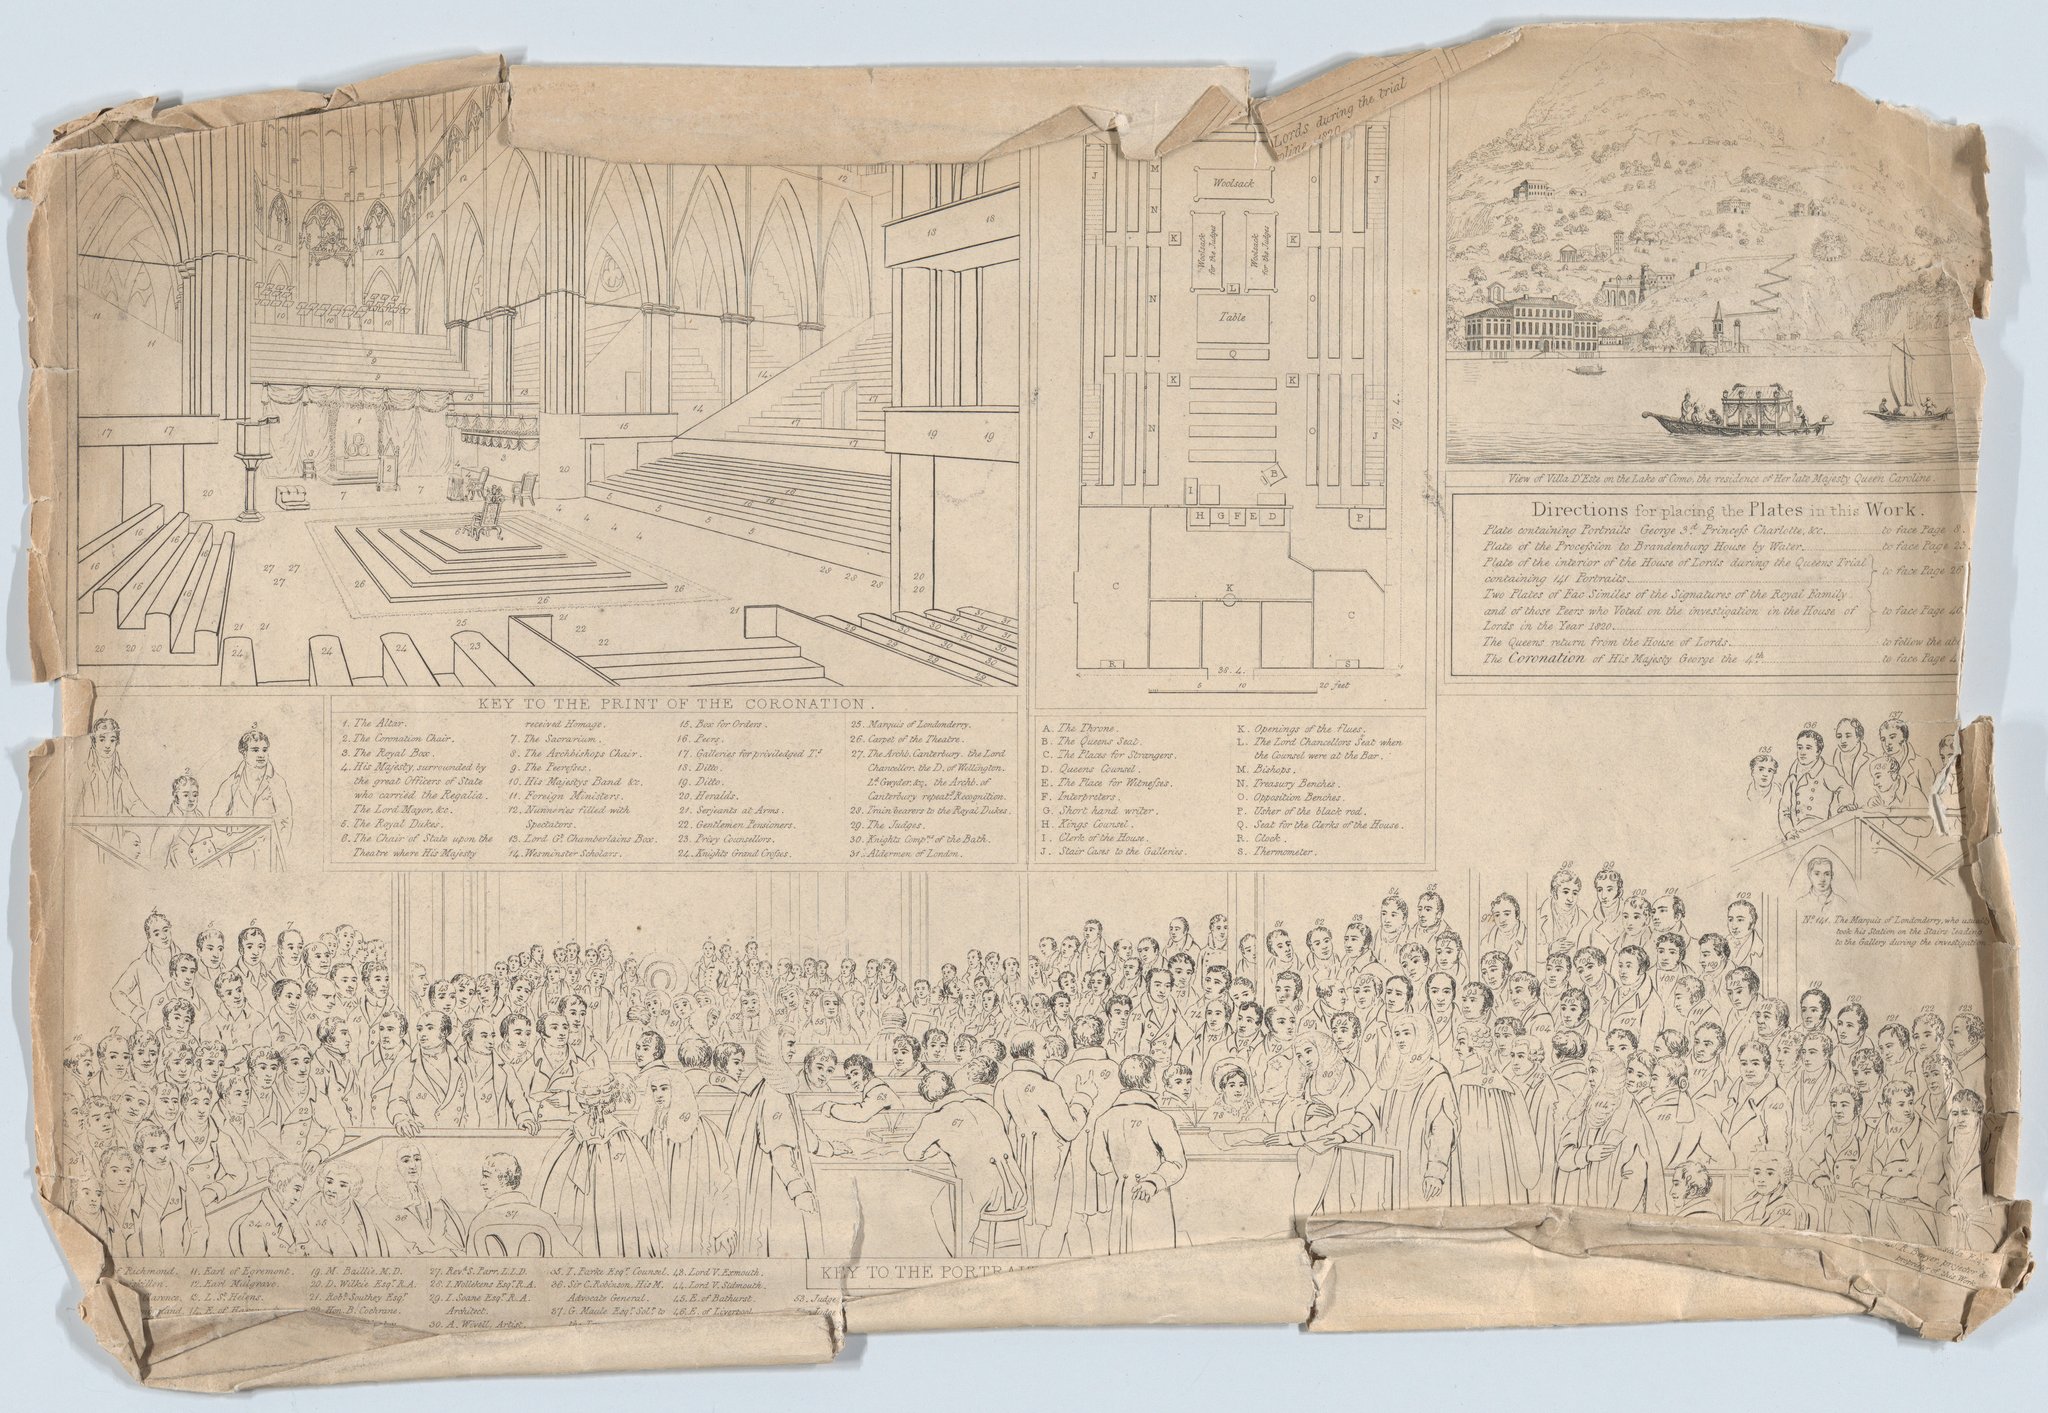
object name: print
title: Keys to Prints of the Coronation of George IV, and Investigation in the House of Lords in 1820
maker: james stephanoff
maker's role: artist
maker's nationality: british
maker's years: 1786-1874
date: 1823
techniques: etching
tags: architecture,men,crowd,boats